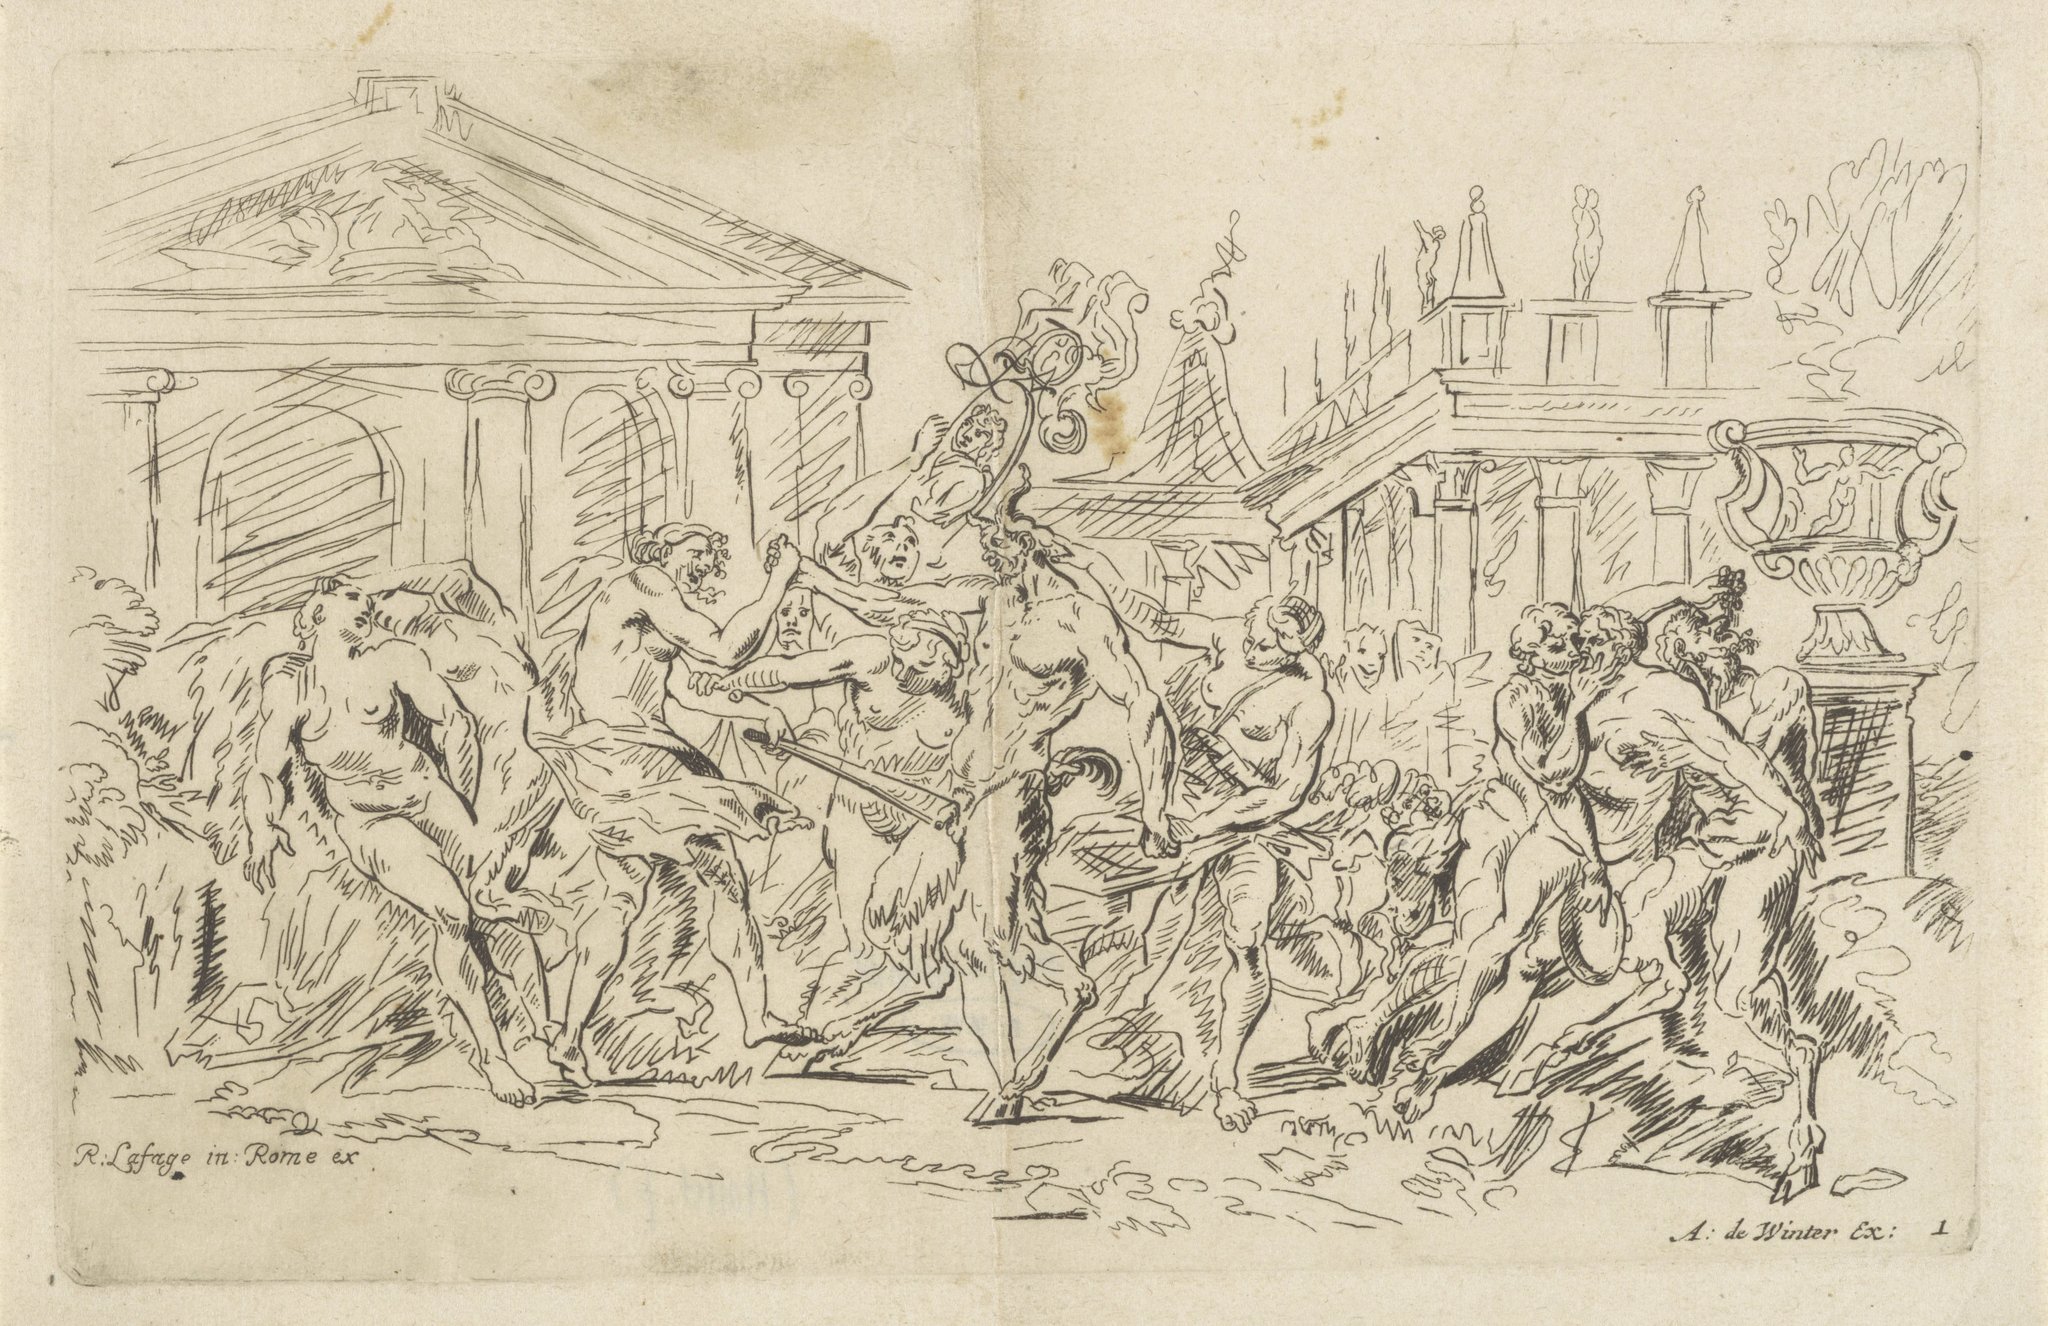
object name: print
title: Sater met dansende nimfen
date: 1668-1707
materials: paper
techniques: etching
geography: rome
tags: thiasos, i.e. bacchus' revel-rout, bacchanal without bacchus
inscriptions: collector's mark: Lugt 2228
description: De sater in het midden met een peniskoker wordt door dansende nimfen omringd. Een persoon achter hem houdt een portret van een man omhoog. Op de achtergrond een klassiek gebouw.